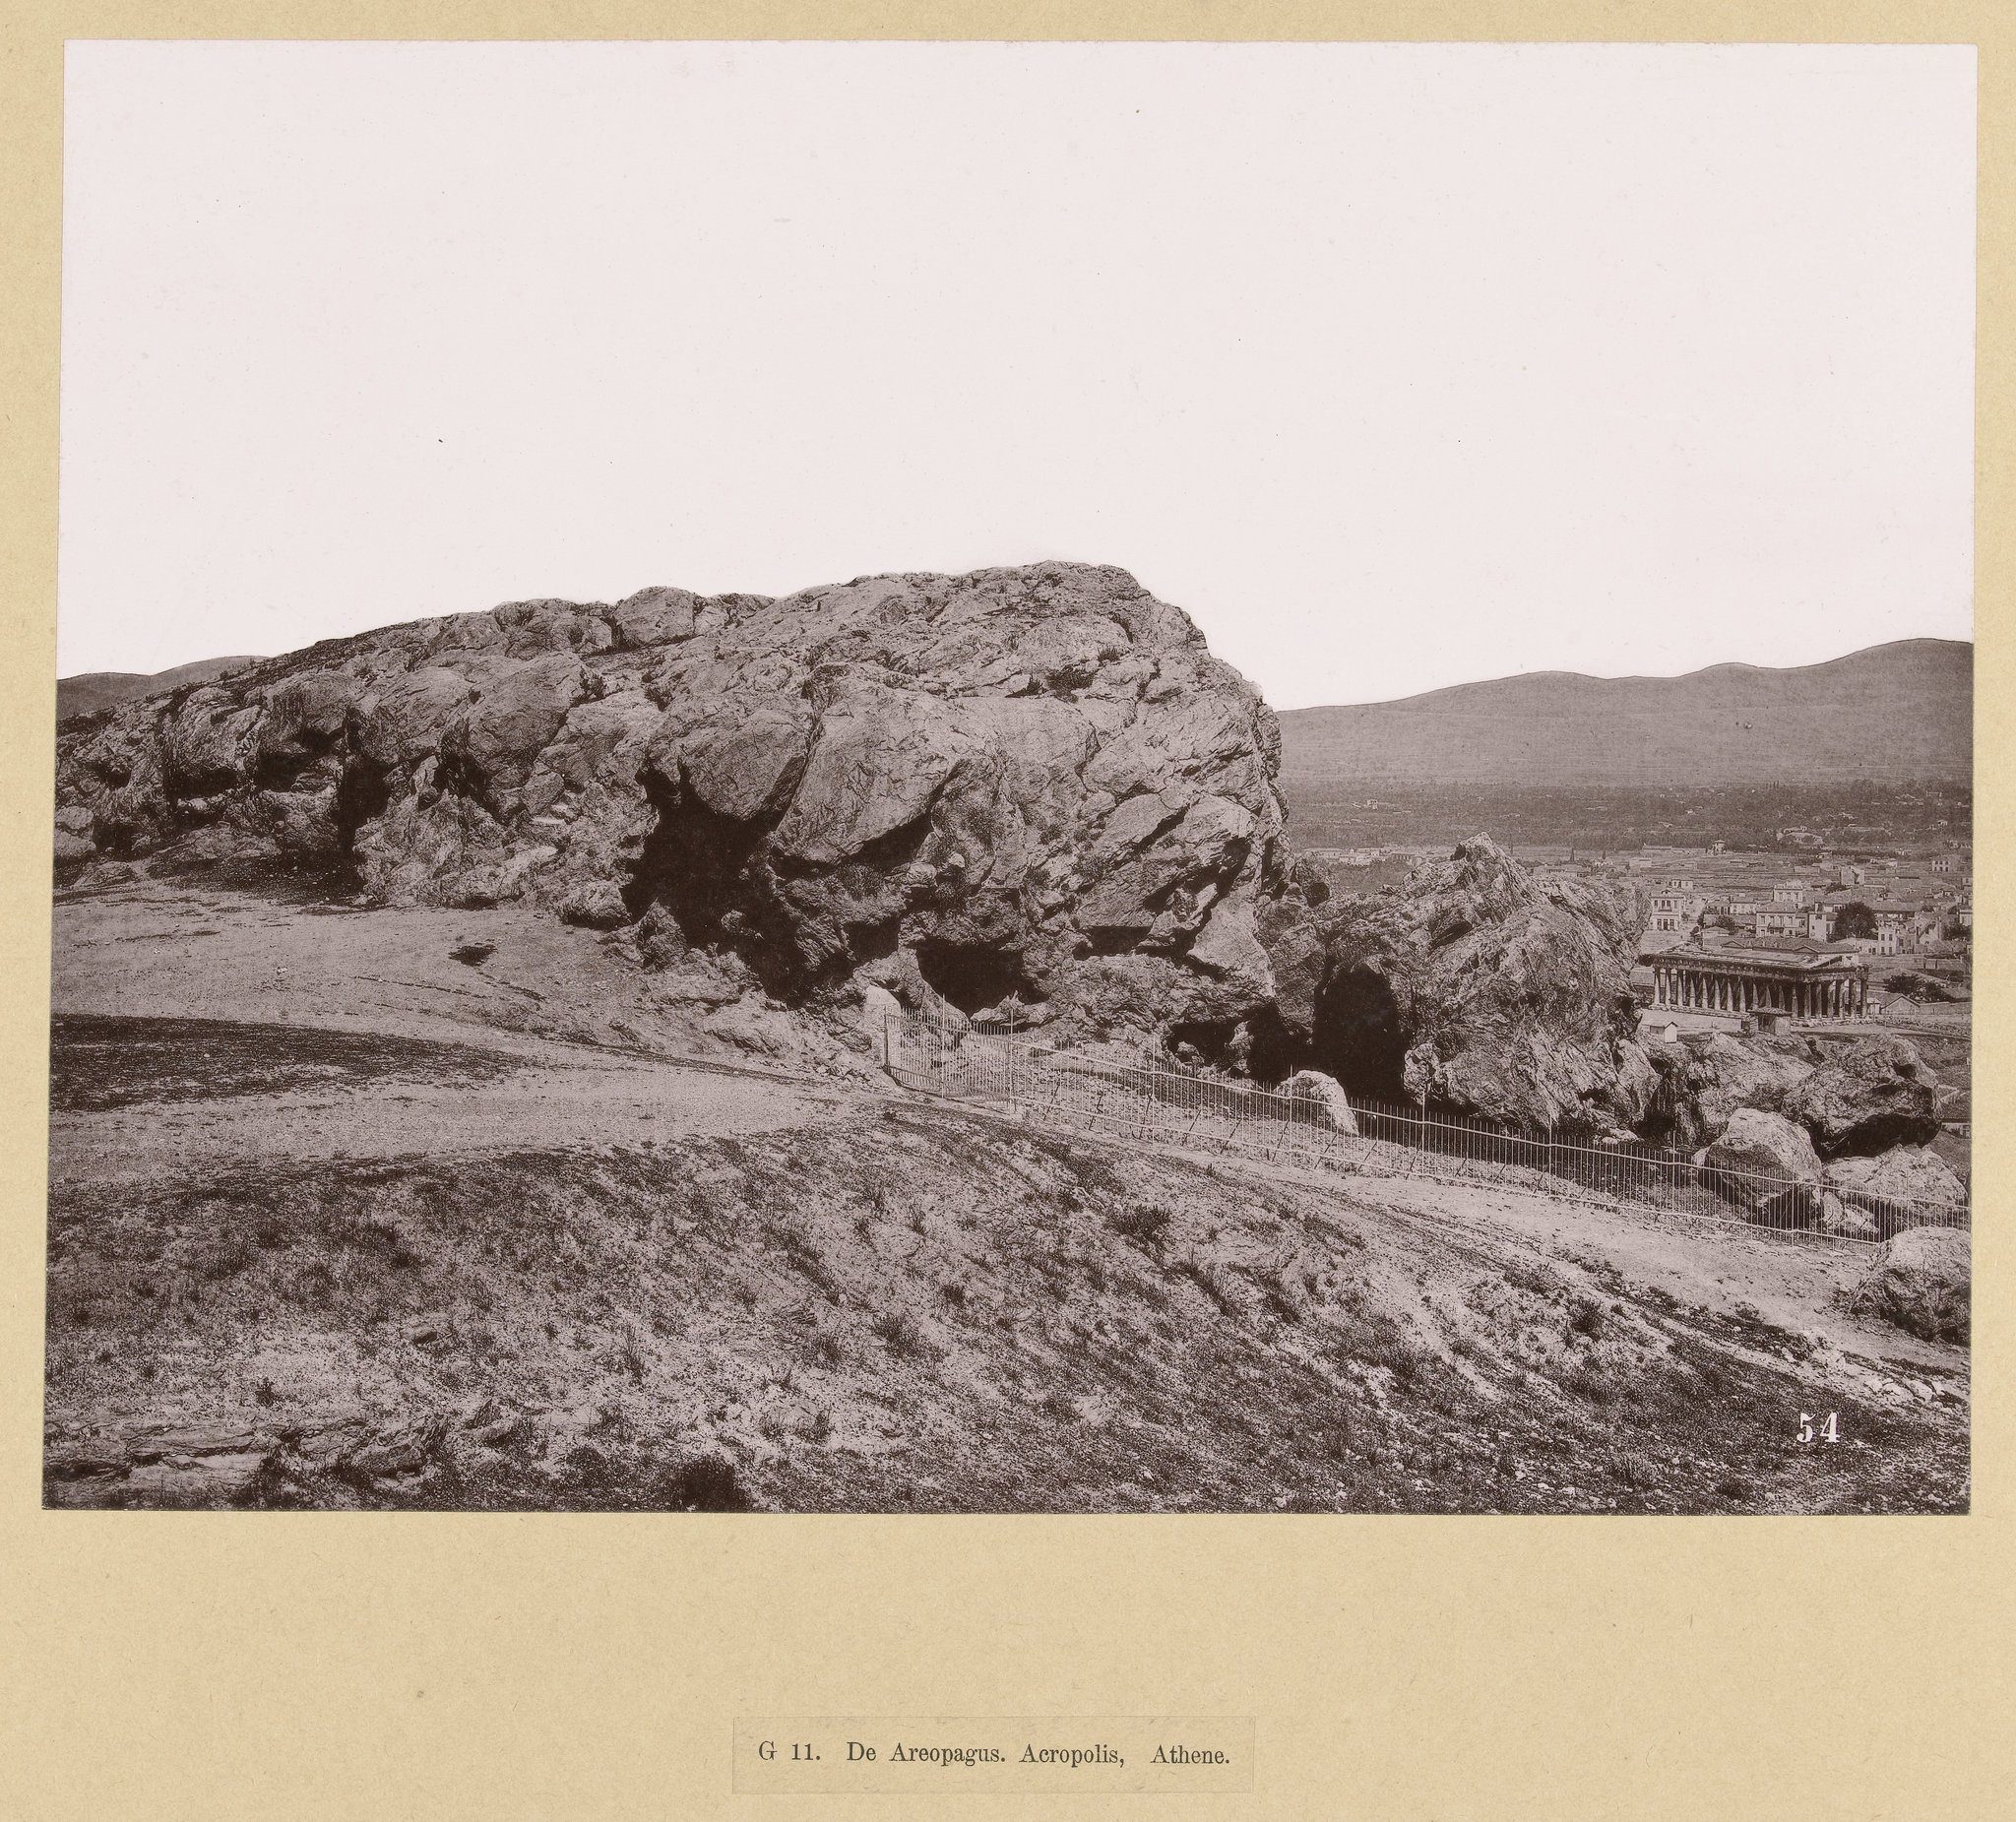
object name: photomechanical print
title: Areopagus te Athene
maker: Anonymous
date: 1890-1893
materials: cardboard, paper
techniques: photograph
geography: athens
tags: city-view in general; 'veduta', rock-formations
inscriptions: check stamp: ‘Bristol/ L.M.’, number: ‘54’, title: ‘G 11. De Areopagus. Acropolis, Athene.’, stamp: ‘Gemeentelijke bibliotheek/ Rotterdam’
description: Onderdeel van een groep door fotograaf Richard Polak op reis verzamelde foto’s. Deze fotomechanische afdruk is samen met andere op zijn reizen verzamelde foto's tentoongesteld bij de Rotterdamsche Kunstkring (1895), Arti en Amicitiae te Amsterdam (1897-1898?) en Societeit 't Collegie te Kampen (datum vooralsnog onbekend).